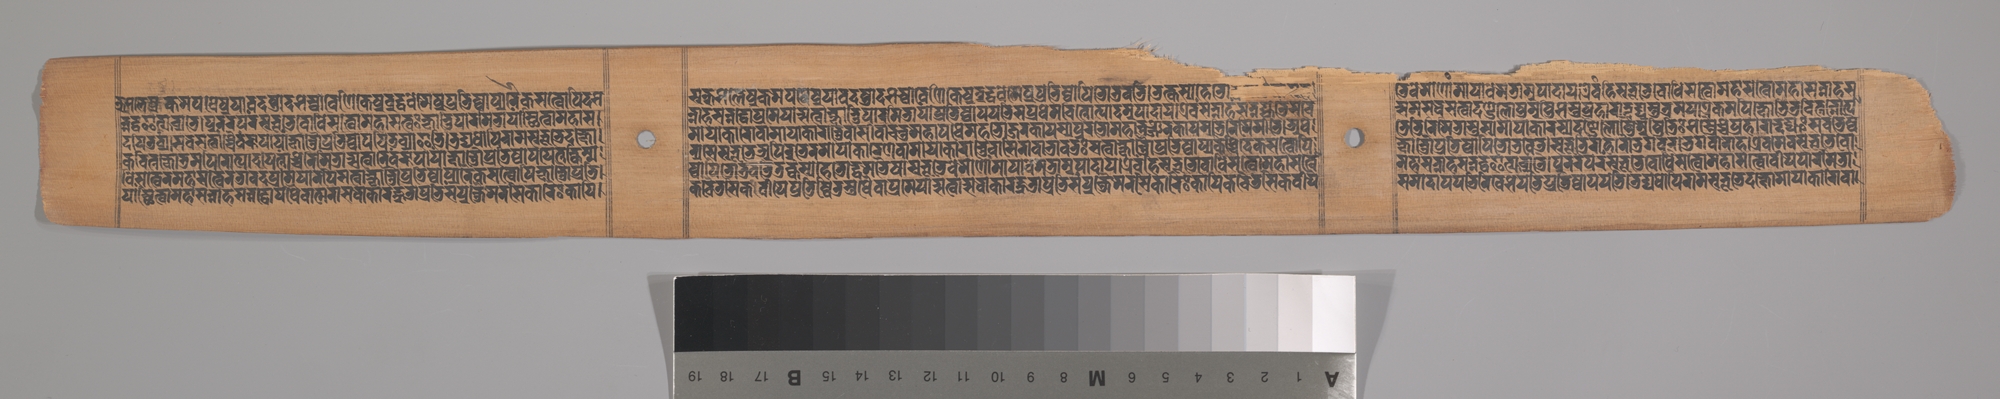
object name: folio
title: Folio from a Manuscript of the Pancavimsatisahasrika Prajnaparamita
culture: indian, bengal or bangladesh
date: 1090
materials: ink, leaf